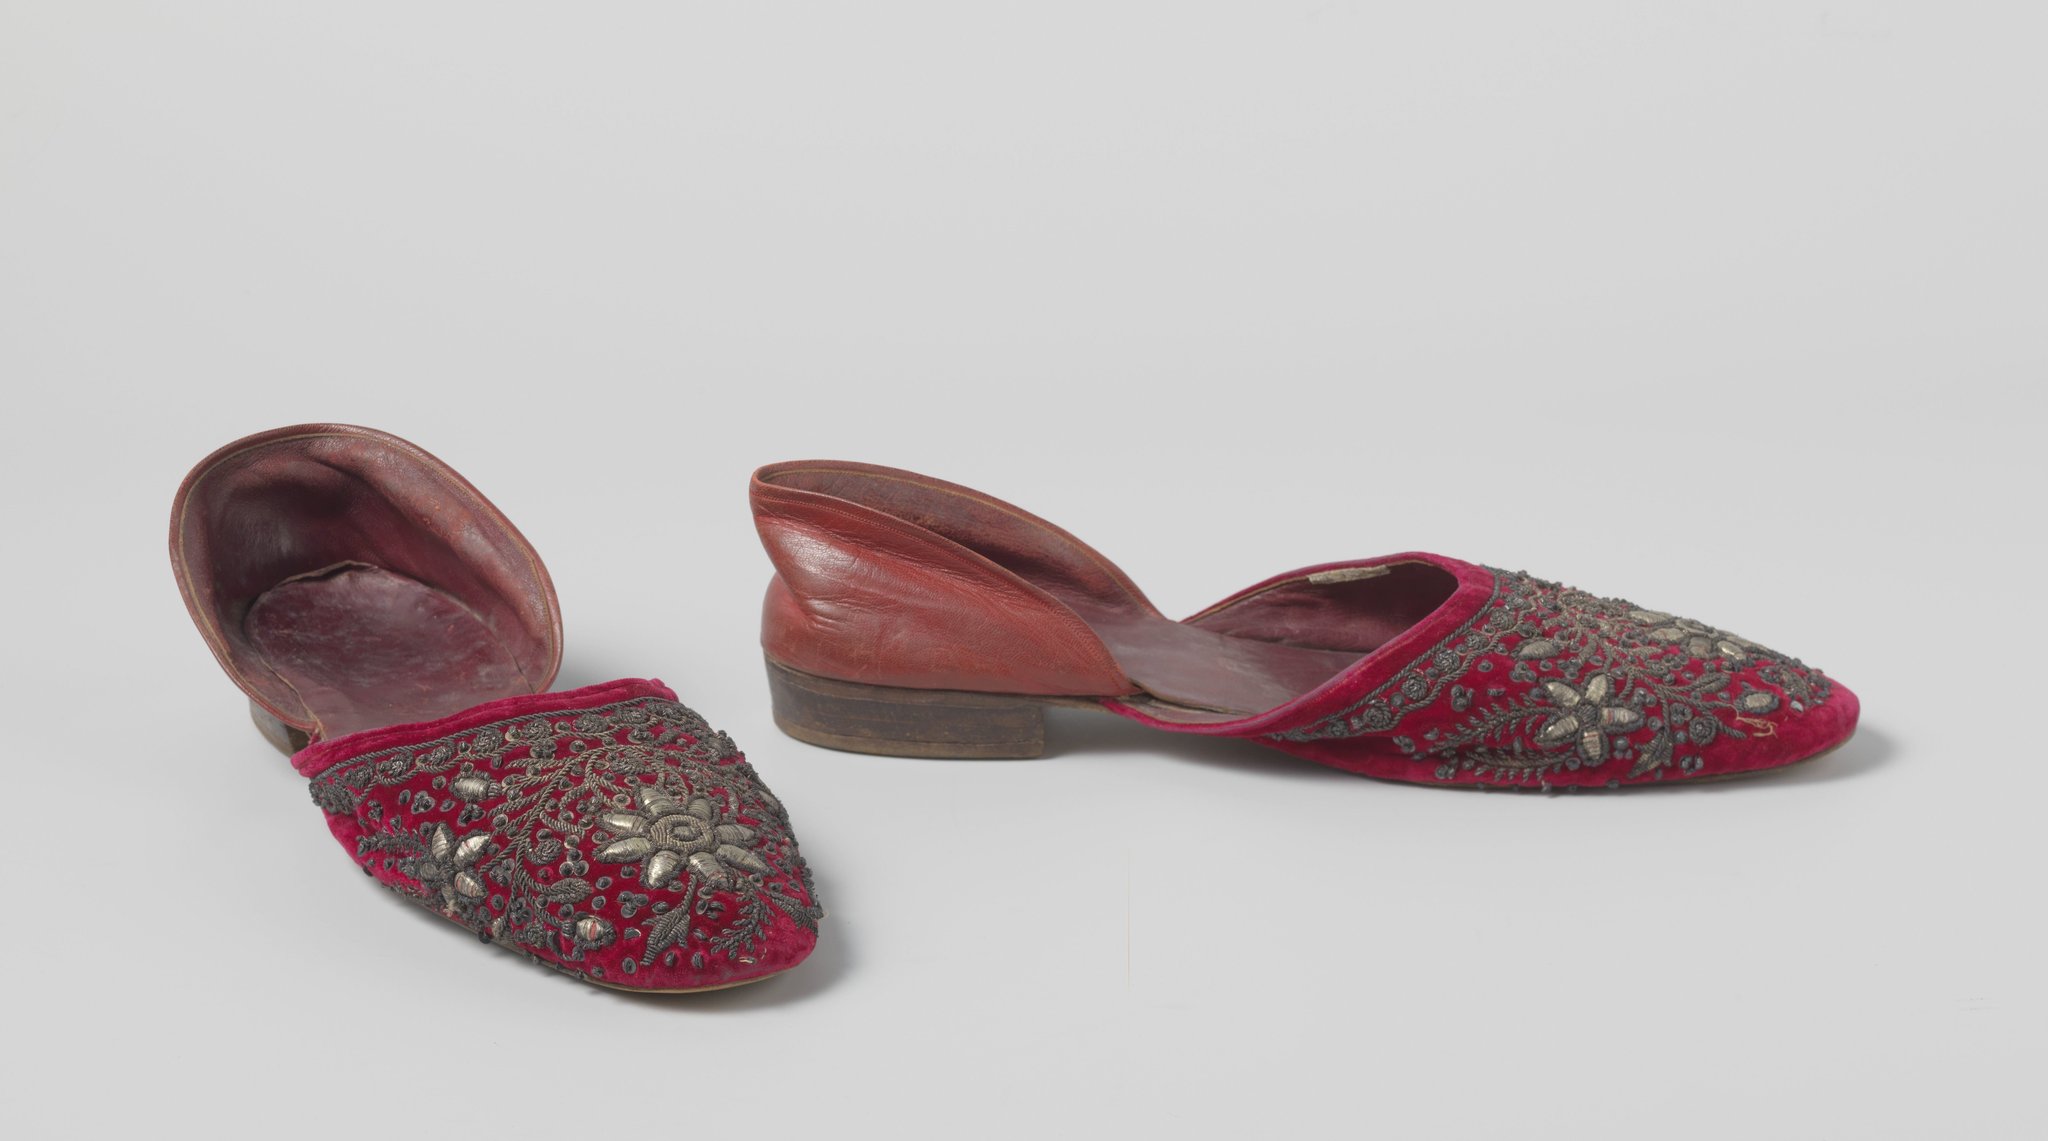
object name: slof, pantoffel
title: Pantoffel van rood leer en rood fluweel met zilverdraad geborduurd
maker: Anonymous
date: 1820-1850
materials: leather, silk, thread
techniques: embroidered, tanning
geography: turkey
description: Pantoffel van rood leer en rood fluweel met zilverdraad geborduurd. Geen verschil tussen links en rechts. Model: ronde neus, een los voorblad en een los achterblad. Kleine rechte hak van leer en leren zool. Geheel gevoerd met rood leer. Versiering: het rode velours is geheel geborduurd met zilverdraad en met paletten. In een patroon van bloemen en takken.